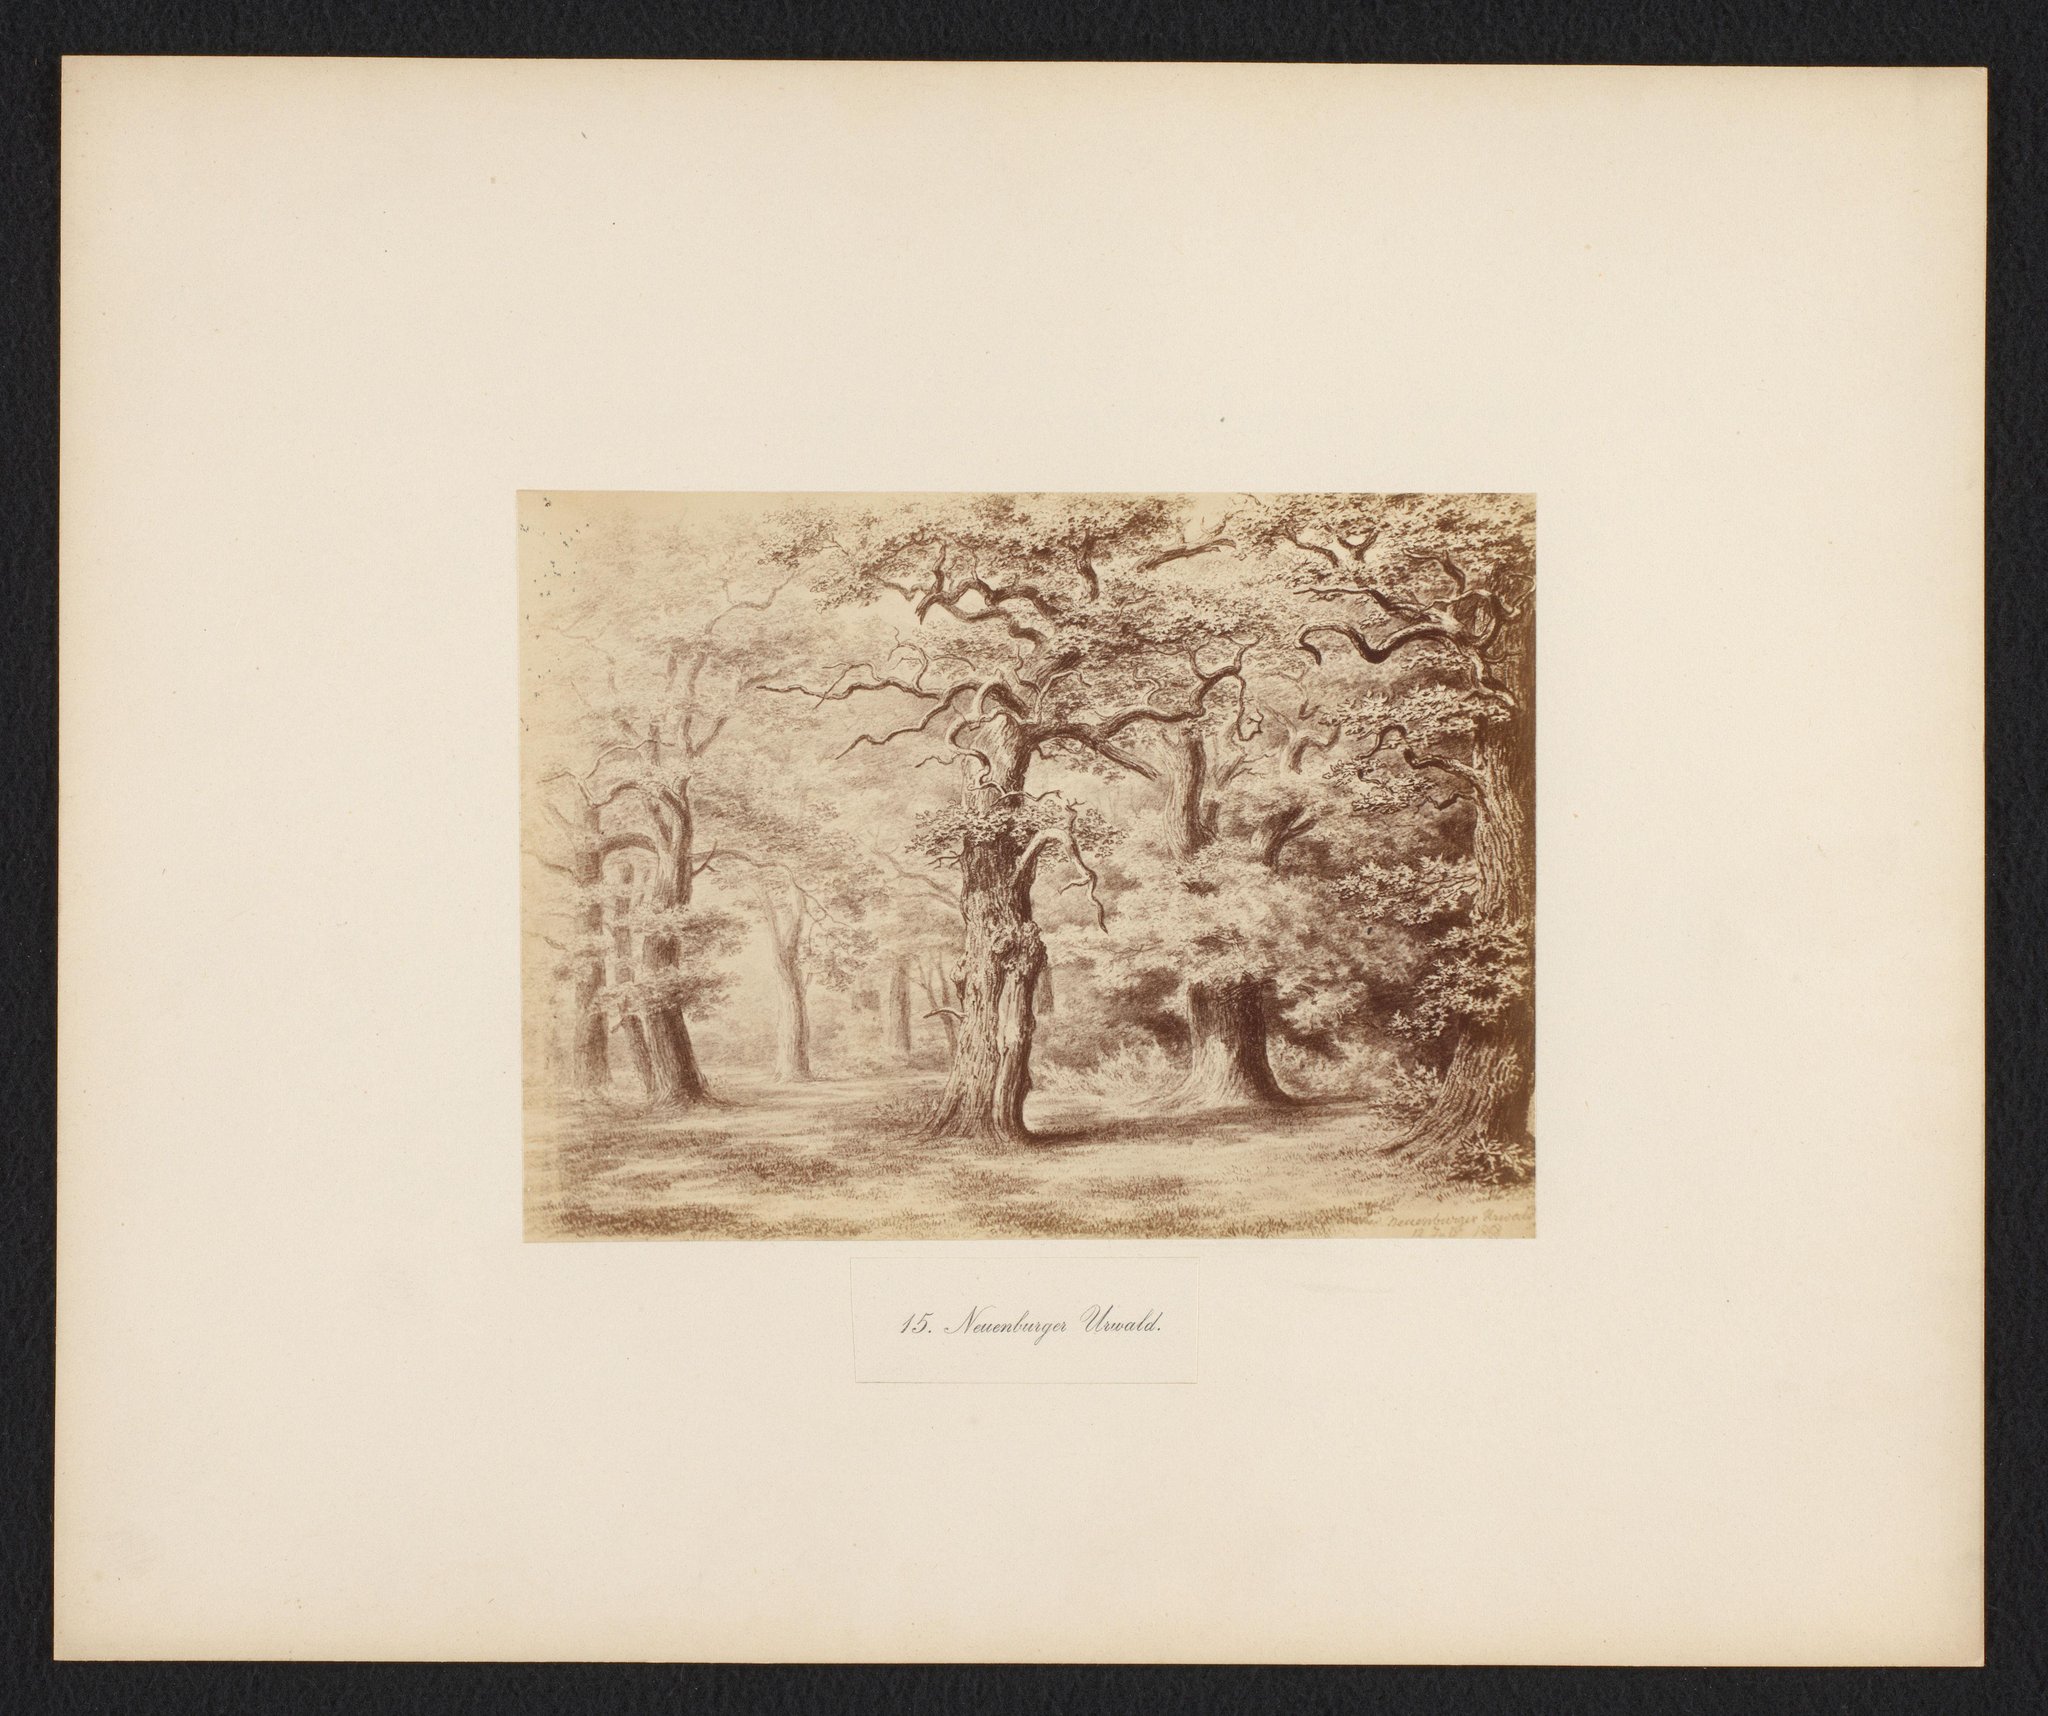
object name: page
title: Fotoreproductie van een tekening van Friedrich Schad van bomen in het Neuenburger Urwald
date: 1870-1875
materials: cardboard, paper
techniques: albumen print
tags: trees